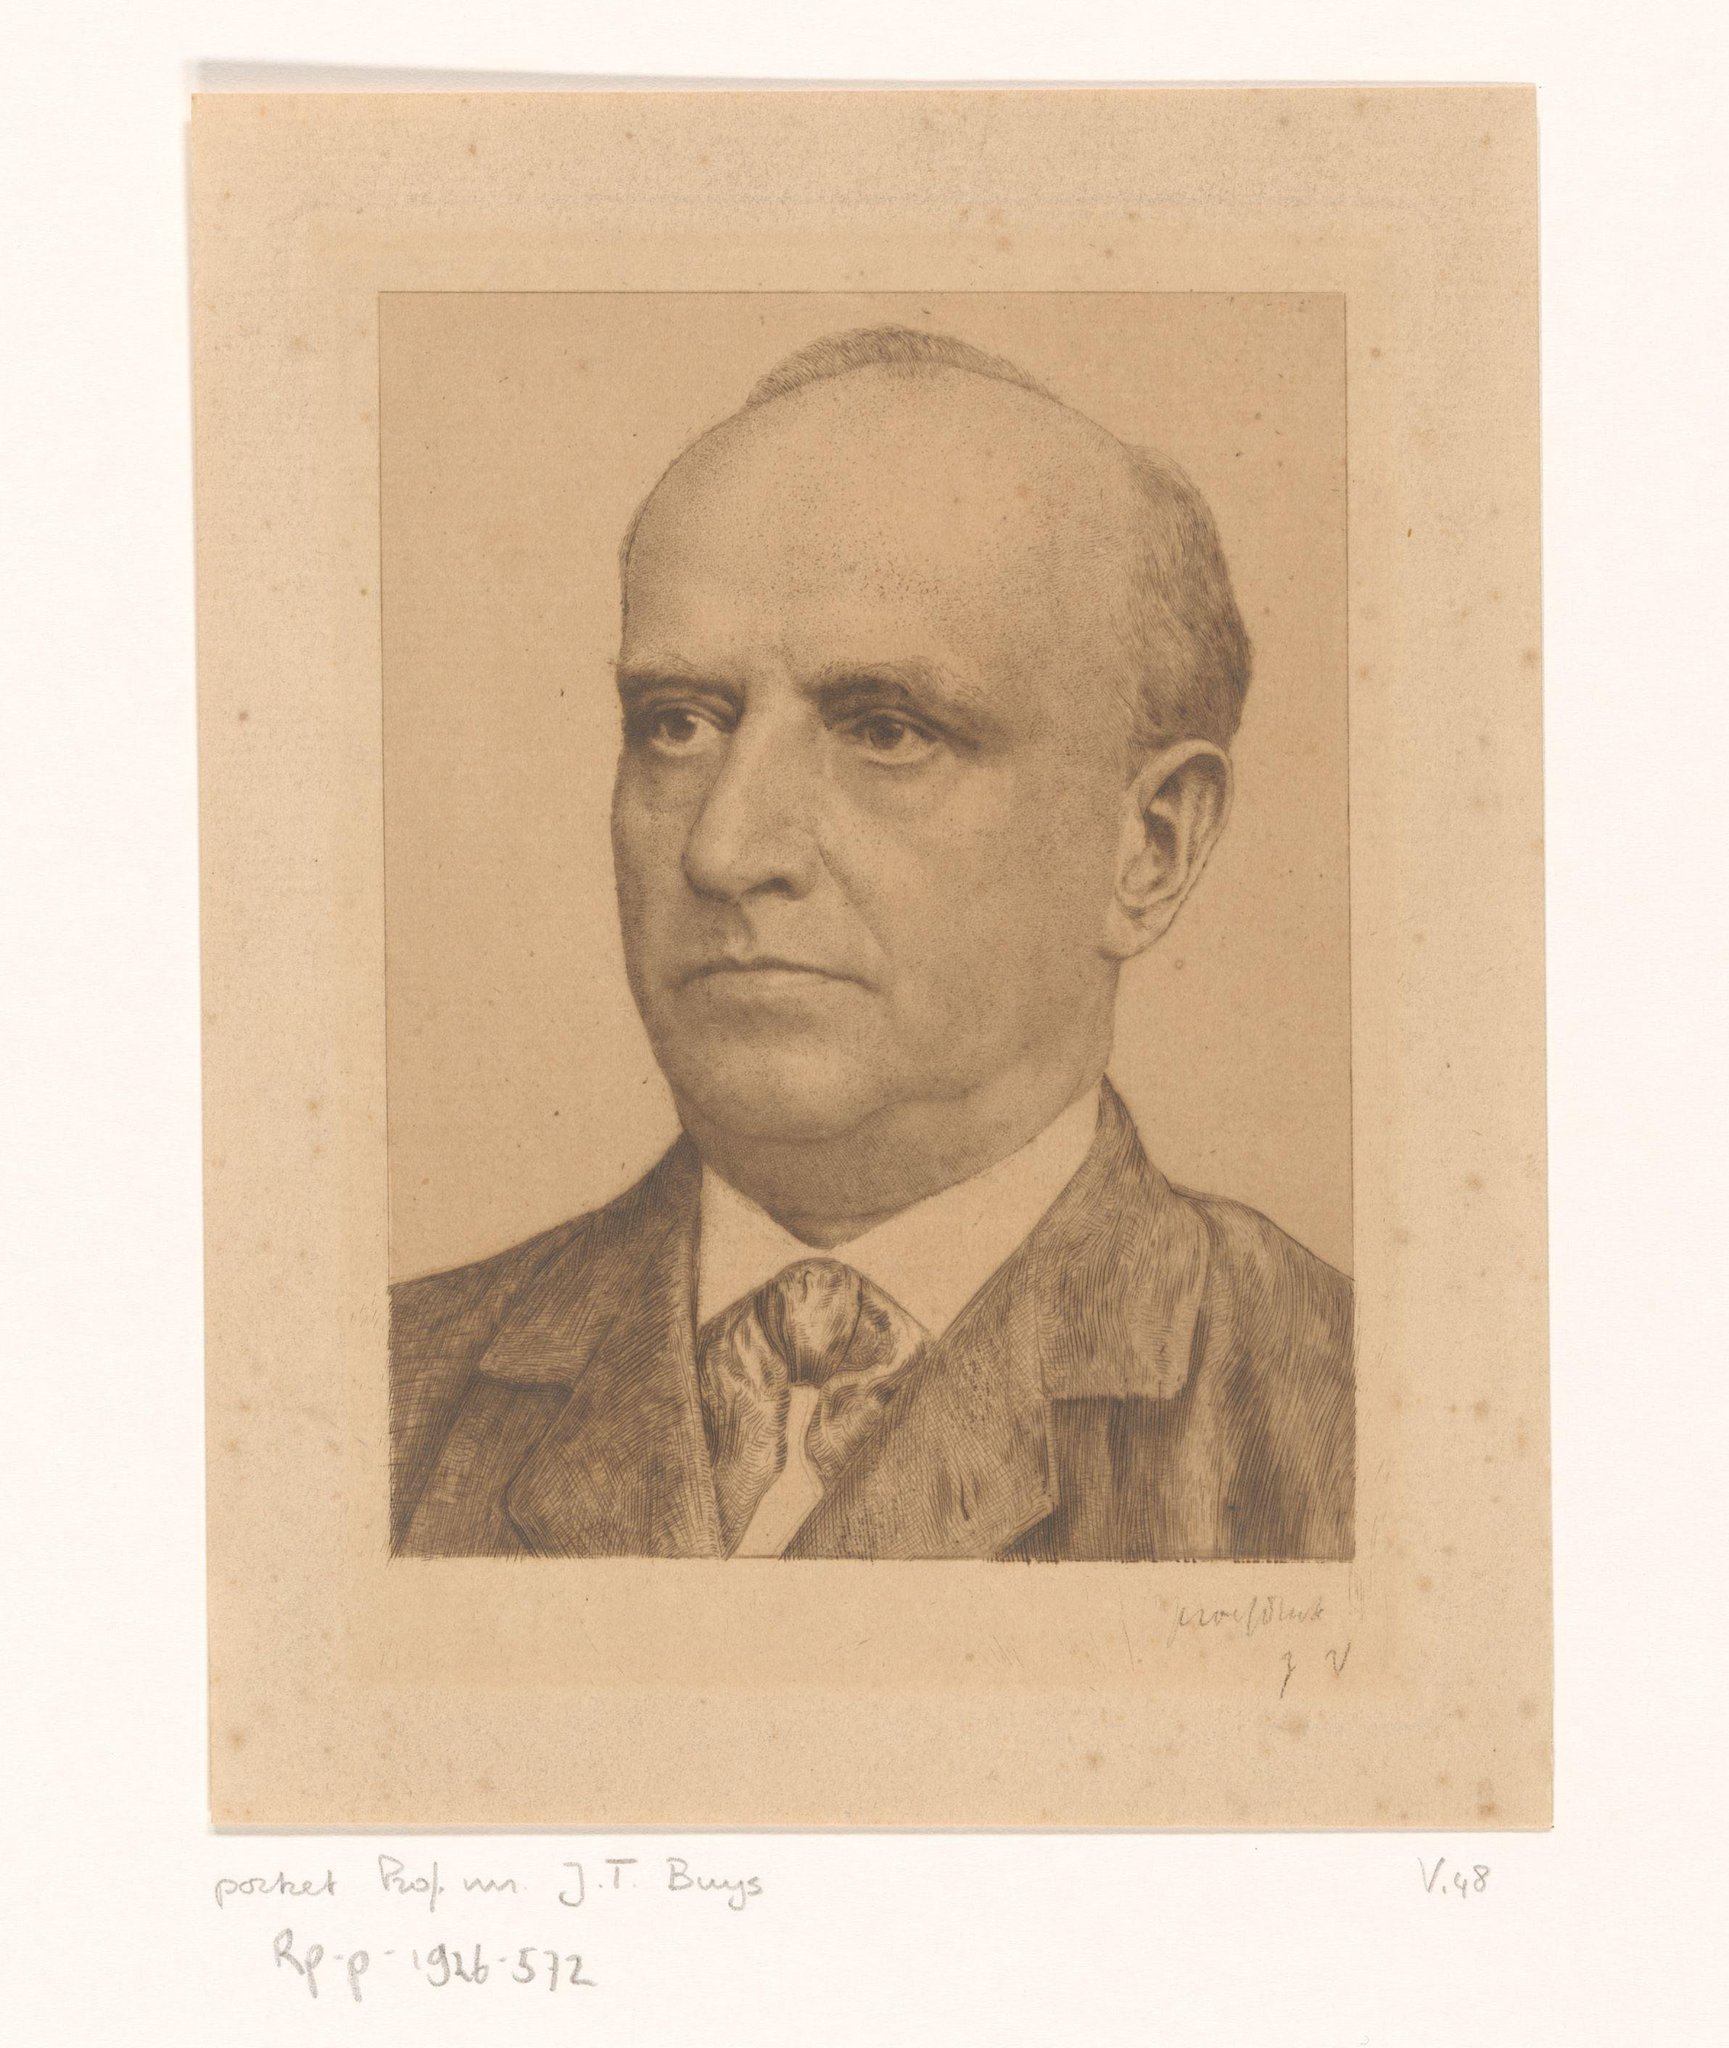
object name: print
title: Portret van Johannes Theodoor Buys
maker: jan veth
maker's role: designer, draughtsman, painter, print maker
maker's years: 1864-1925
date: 1893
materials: paper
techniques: etching, intaglio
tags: warmond, historical persons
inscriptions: collector's mark: Lugt 2228